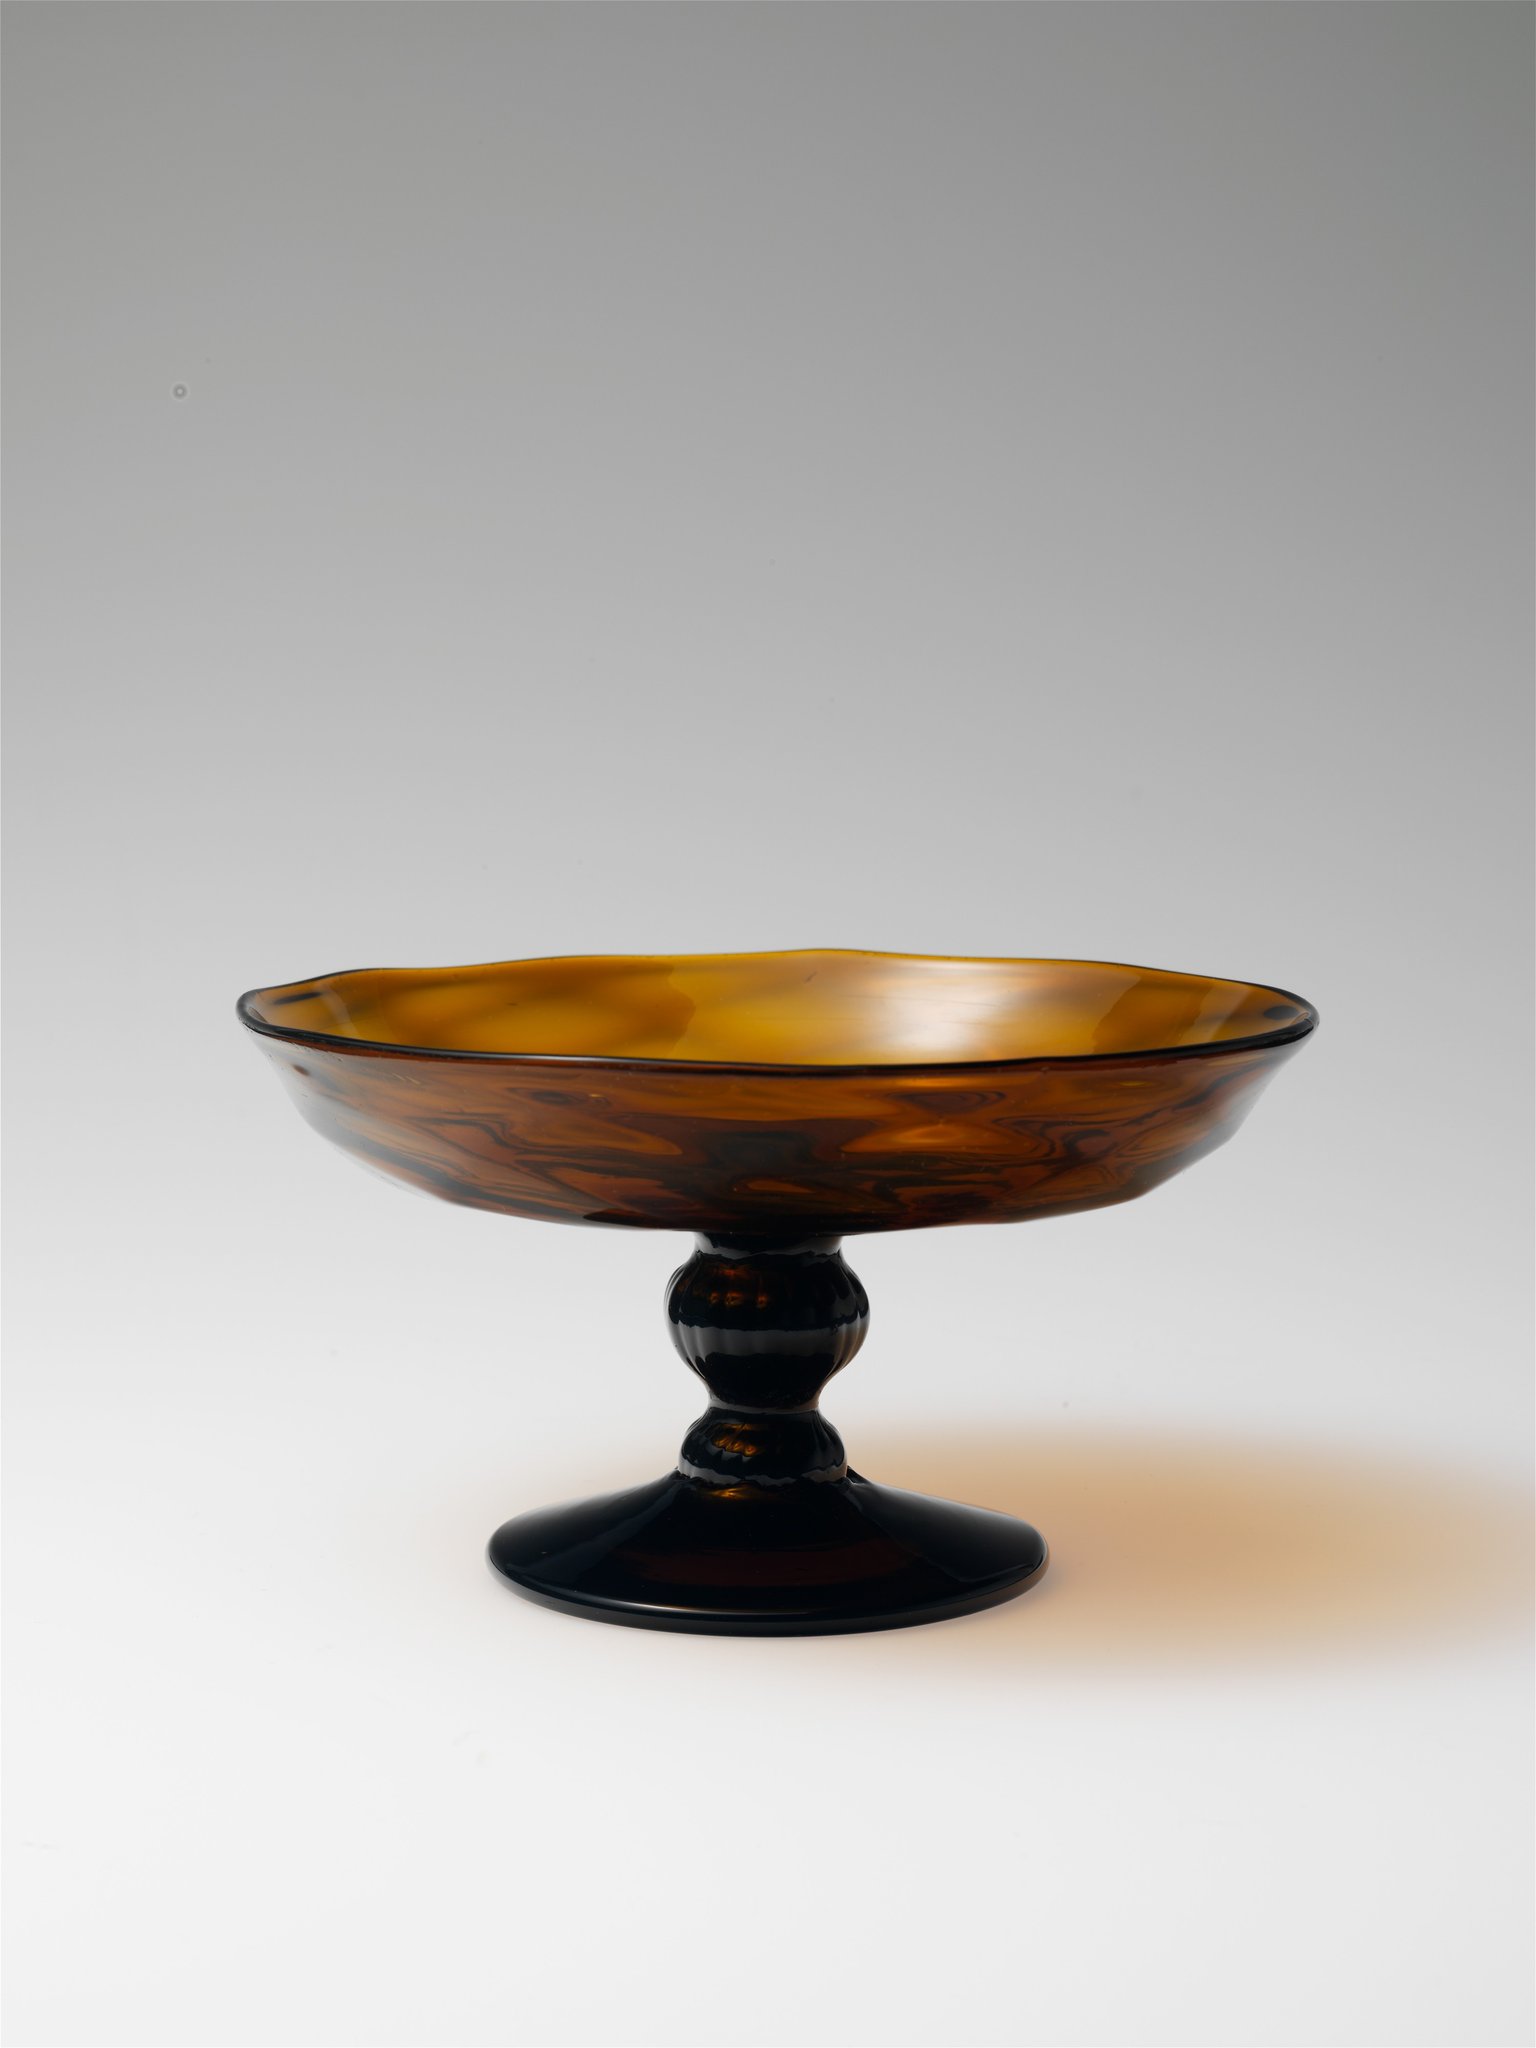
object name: compote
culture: american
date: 1815-1835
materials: glass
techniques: glassblowing, molding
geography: united states